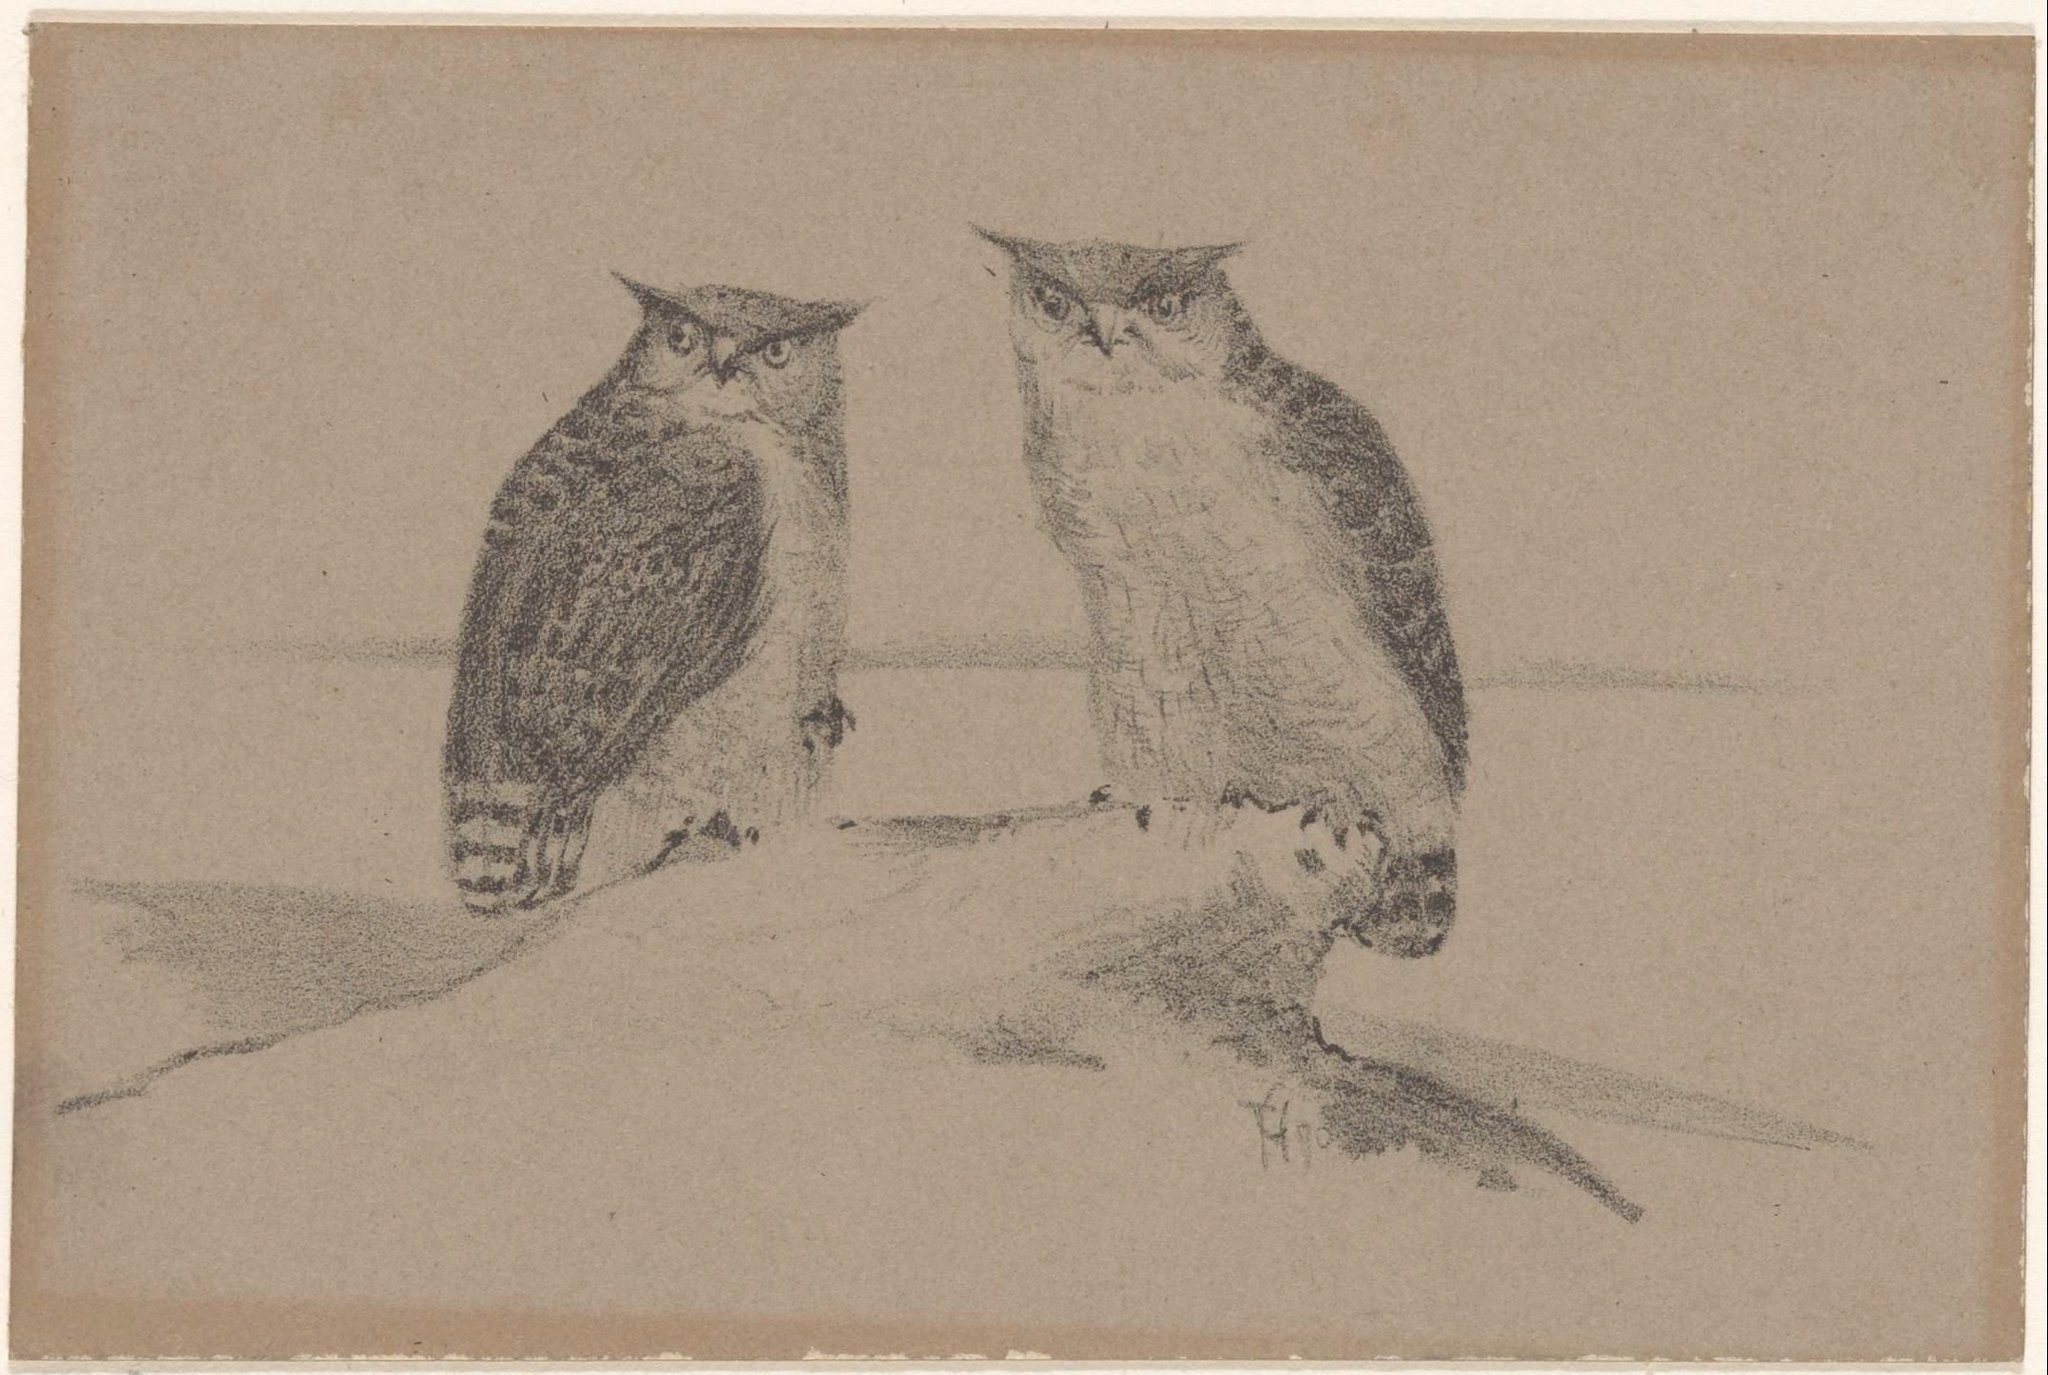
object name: greeting card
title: Wenskaart met twee uilen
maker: theo van hoytema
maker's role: draughtsman, painter, print maker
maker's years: 1863-1917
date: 1890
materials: paper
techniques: lithograph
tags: owls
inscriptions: number: ‘626’, collector's mark: Lugt 2228